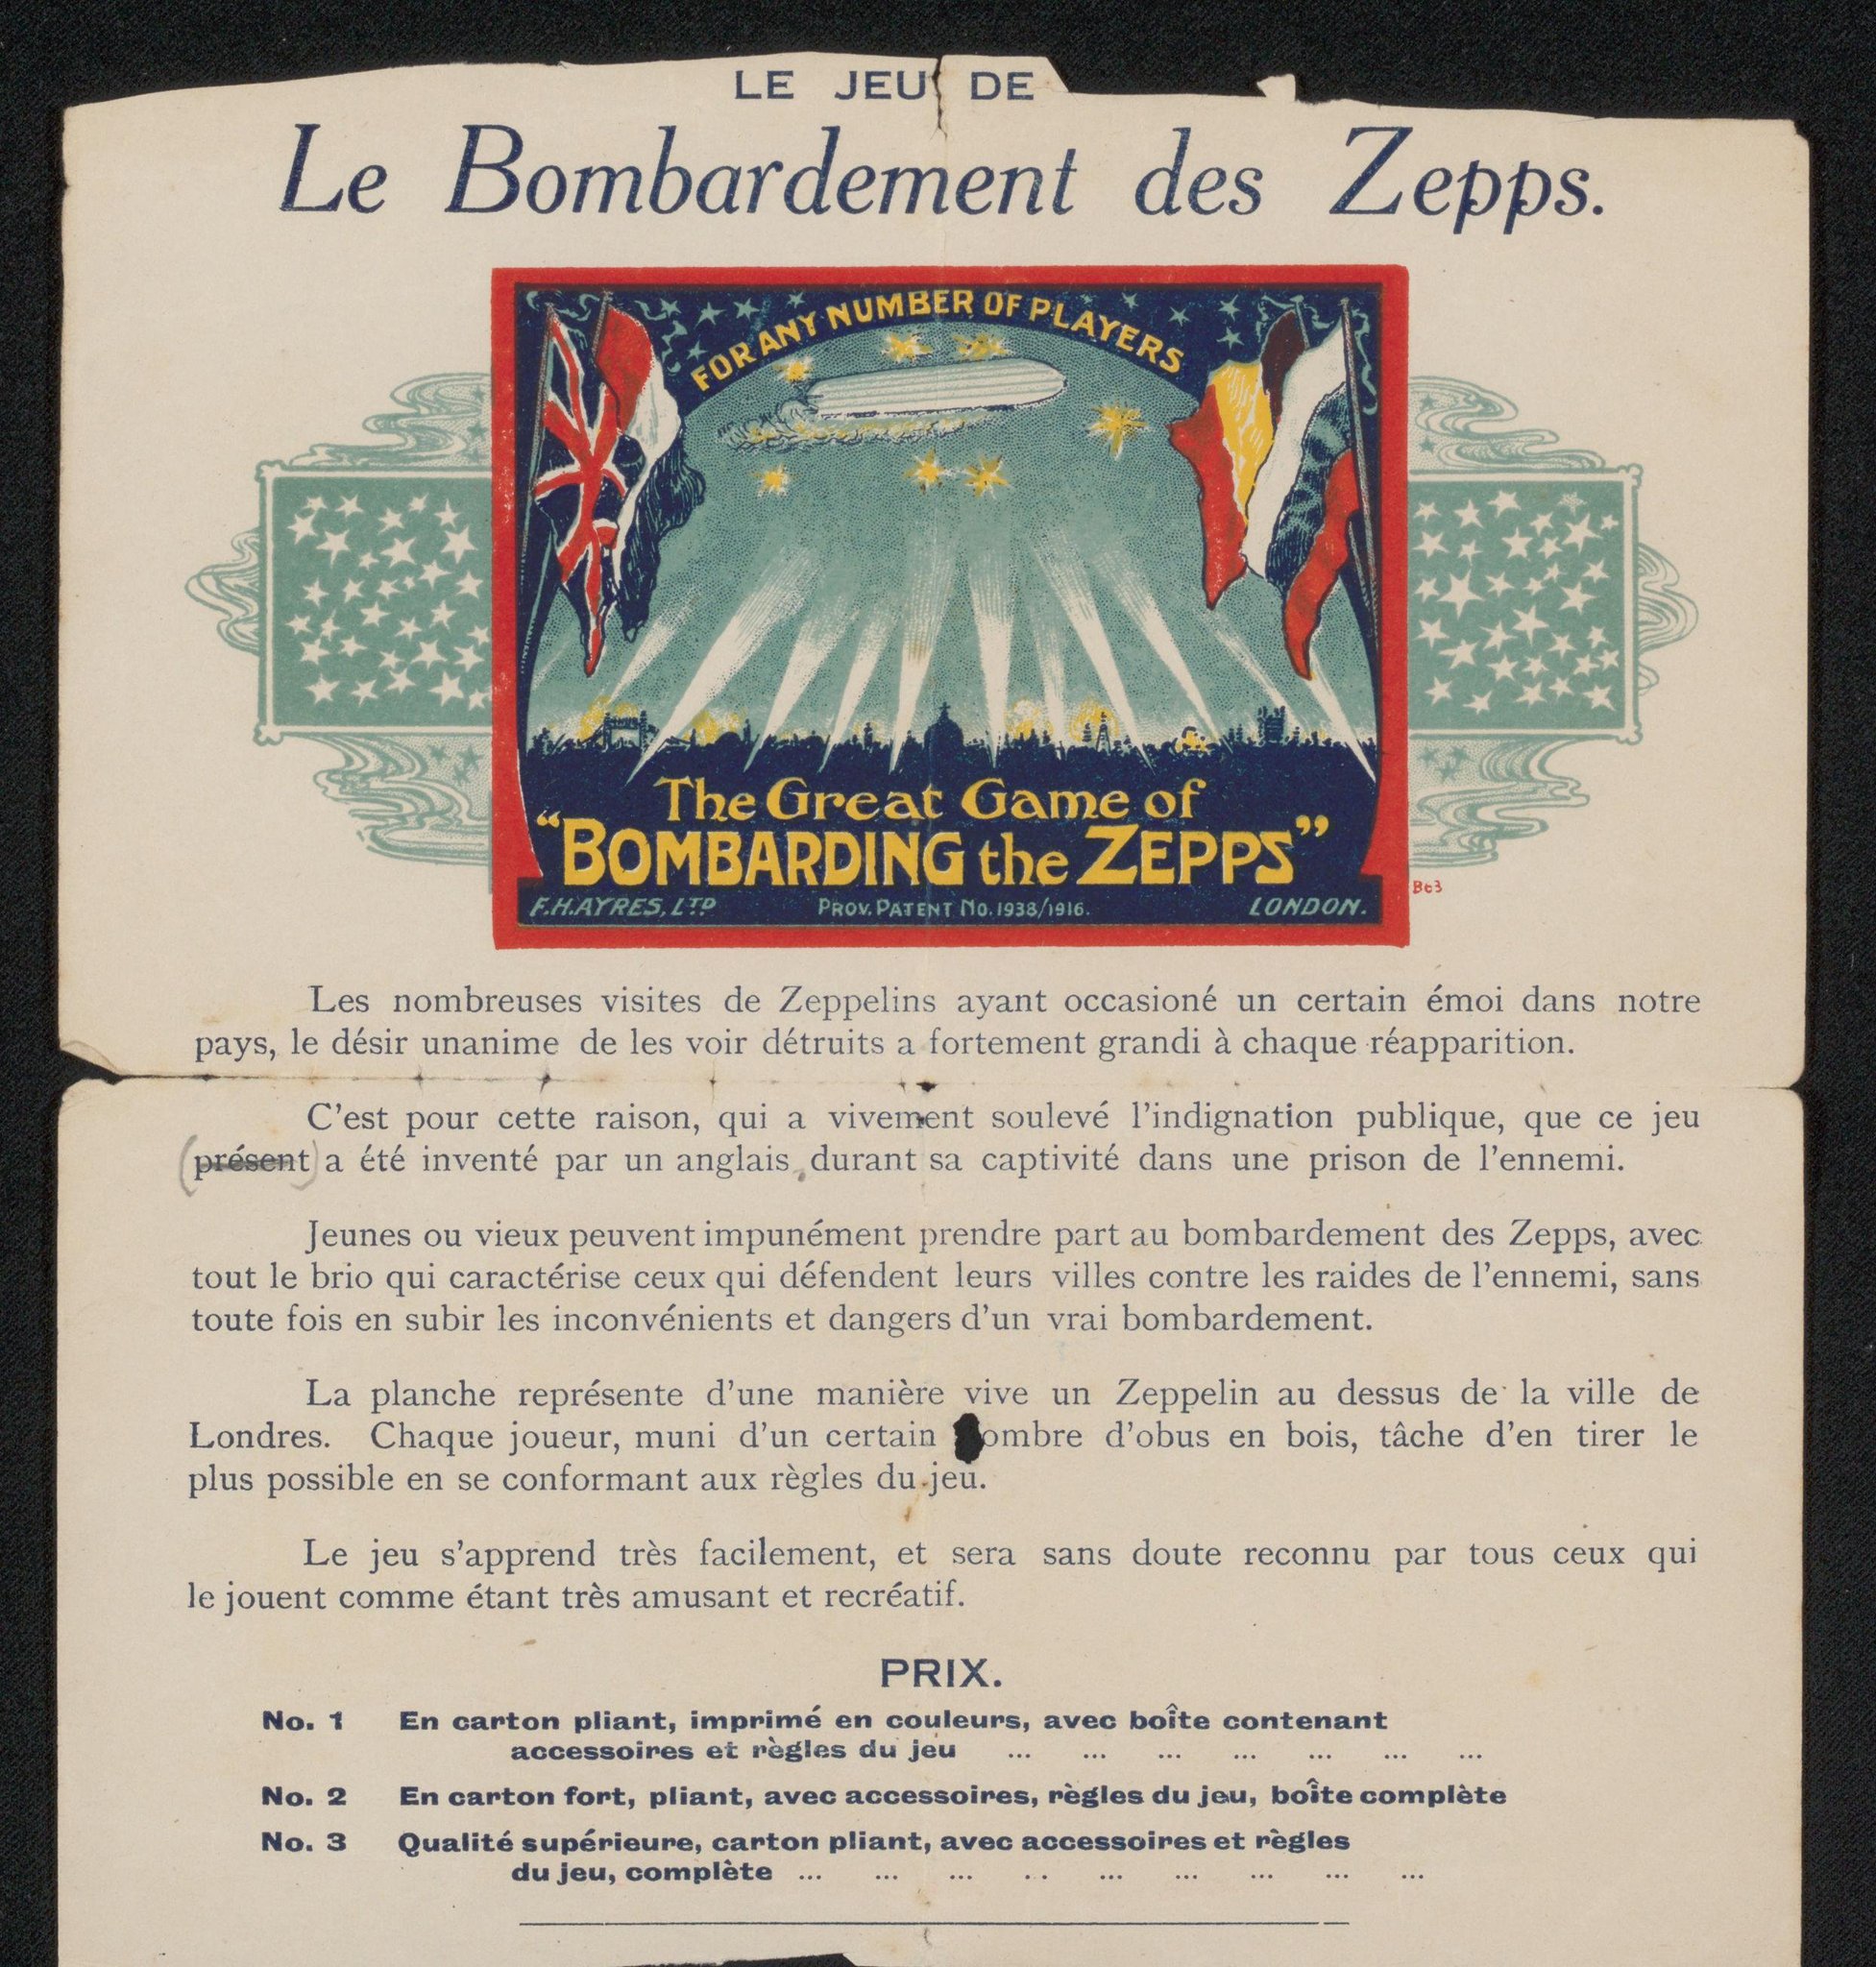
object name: document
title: Document uit archief Philip Zilcken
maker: Anonymous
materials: paper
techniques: printing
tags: the hague, painter, draughtsman, philip zilcken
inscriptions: collector's mark: ‘RPK’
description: Introductie van het spel Le Bombardement des Zepps, oorspronkelijk Bombarding the Zepps van F.H. Ayres Ltd in Londen.